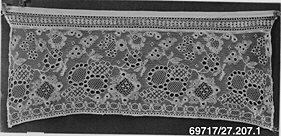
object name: strip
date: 1800-1820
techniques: lace